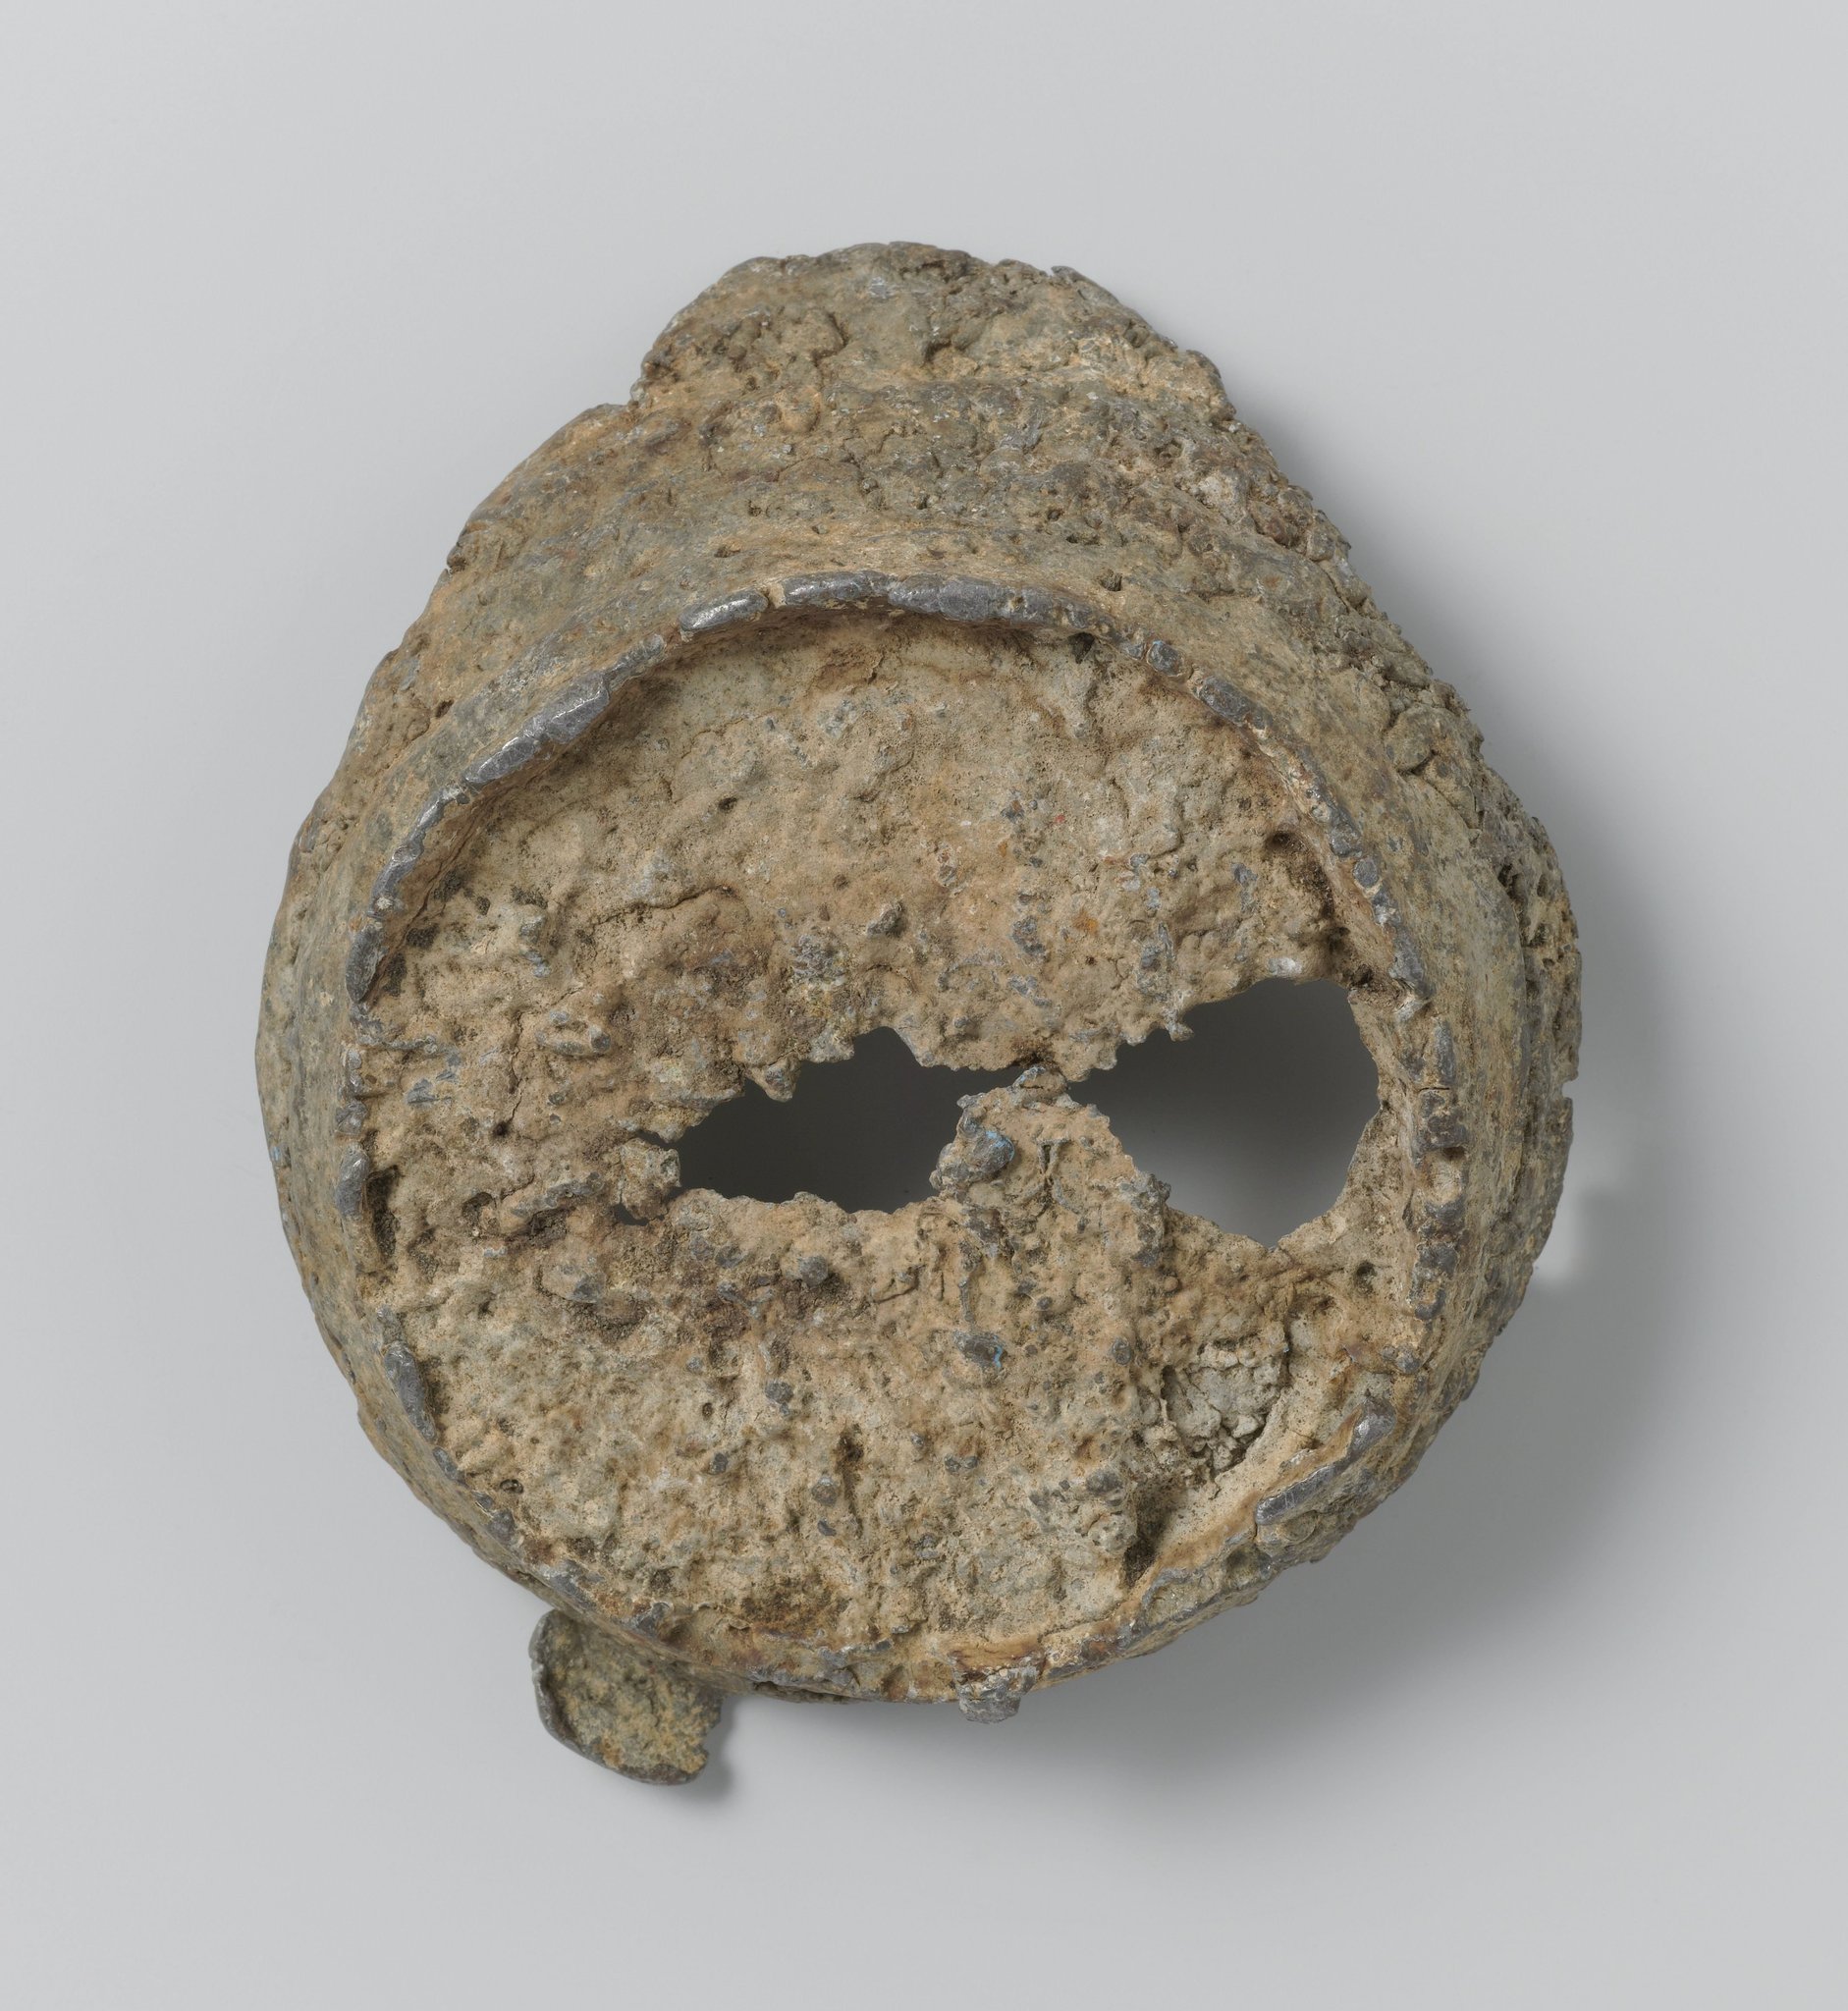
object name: ewer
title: Fragment van kruik, stuk gegoten lood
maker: Anonymous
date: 1590-1596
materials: lead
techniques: soldering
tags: willem barendsz., amsterdam, jacob van heemskerck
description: Fragment, stuk gesmolten lood. Betreft of de bodem van een tinnen kruik of lood dat in een kruik van ceramiek gegoten is.